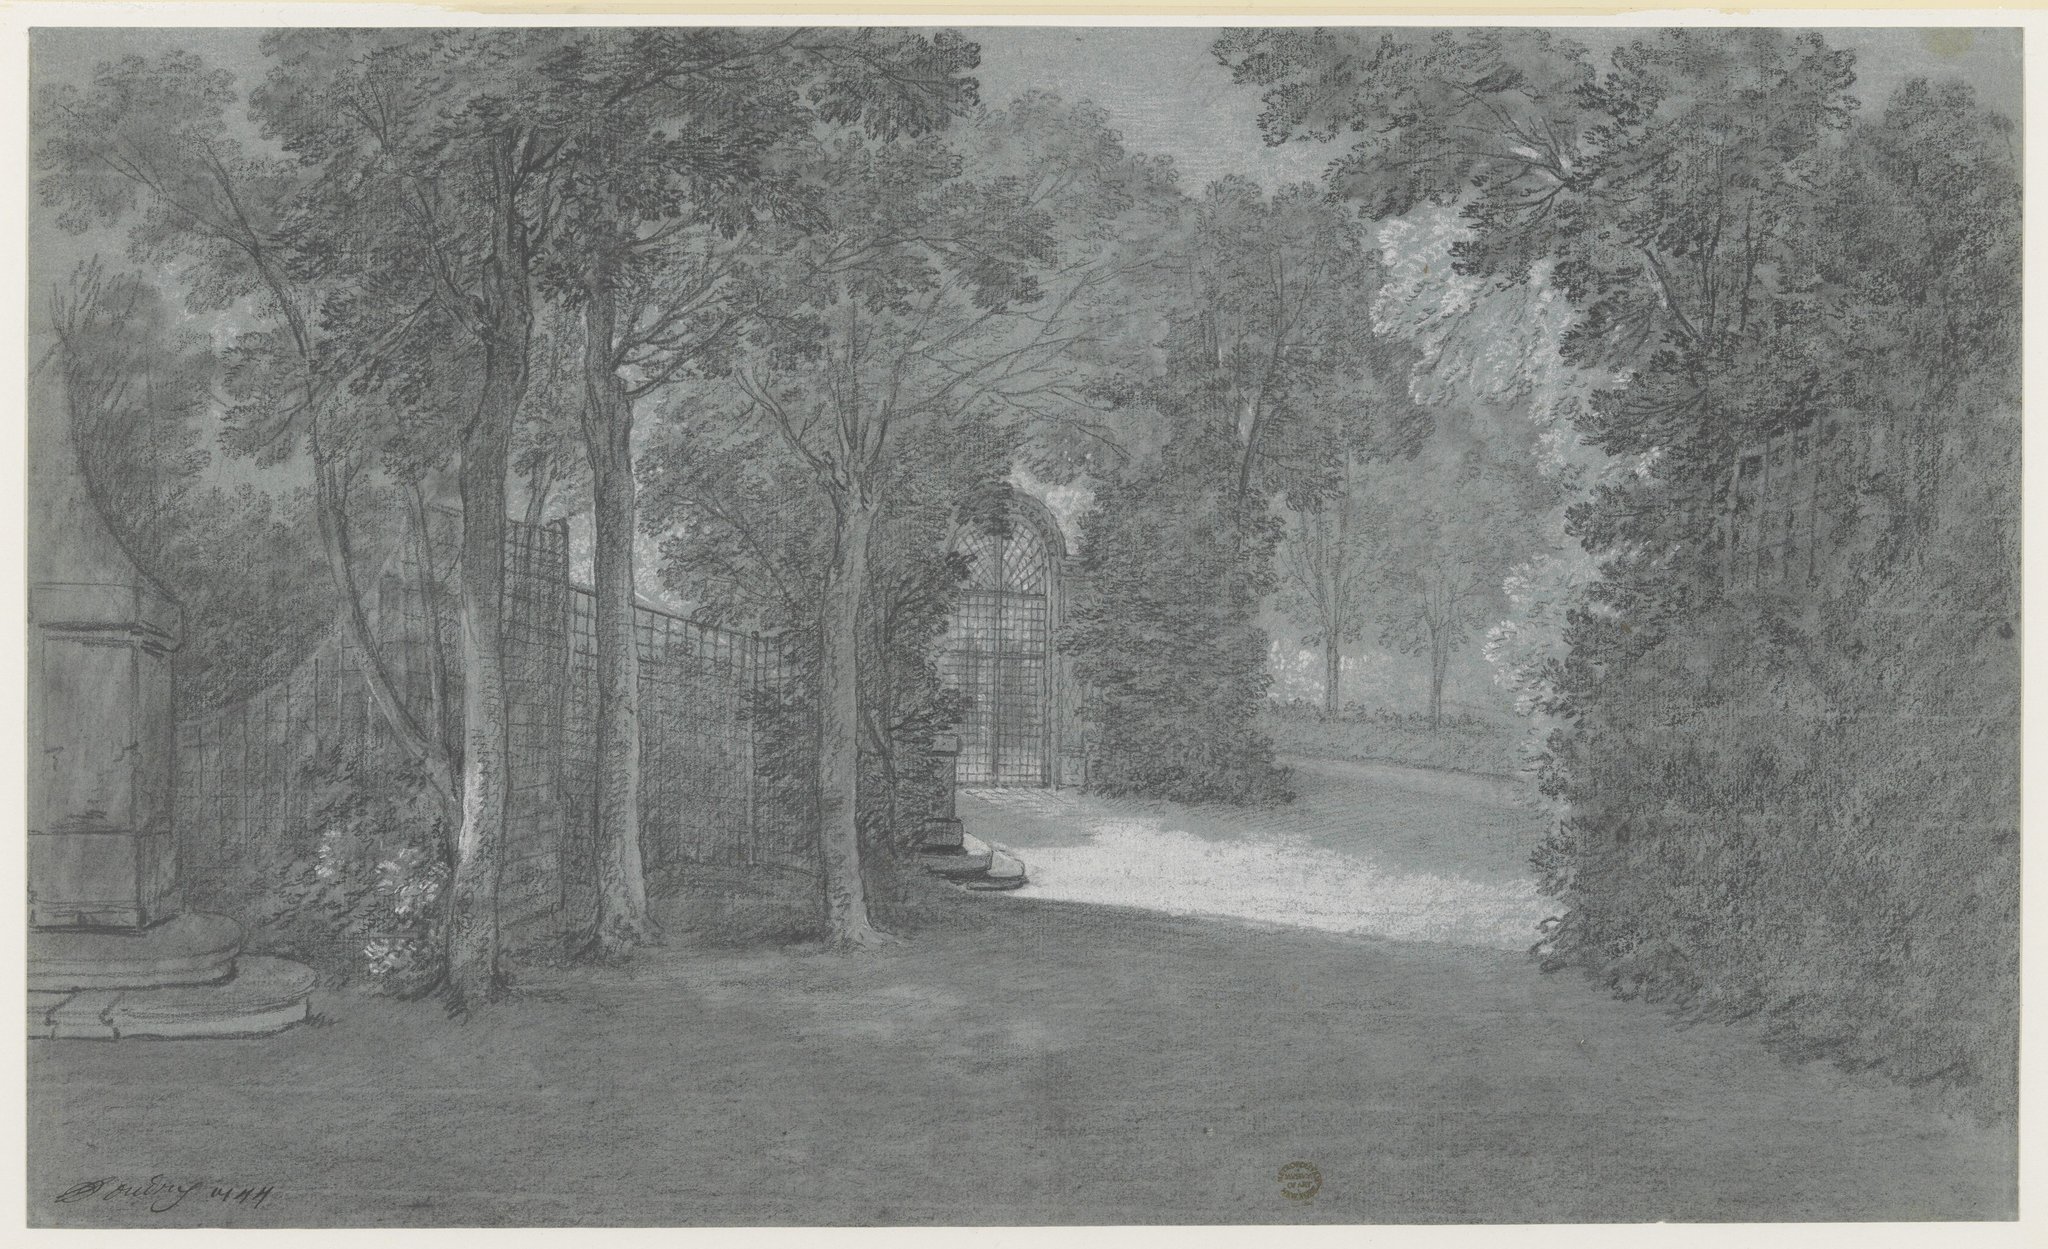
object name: drawing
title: View in the Gardens of Arcueil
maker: jean-baptiste oudry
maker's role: artist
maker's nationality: french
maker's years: 1686-1755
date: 1744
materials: chalk, charcoal, paper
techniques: heightening, stumping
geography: france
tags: gardens,trees